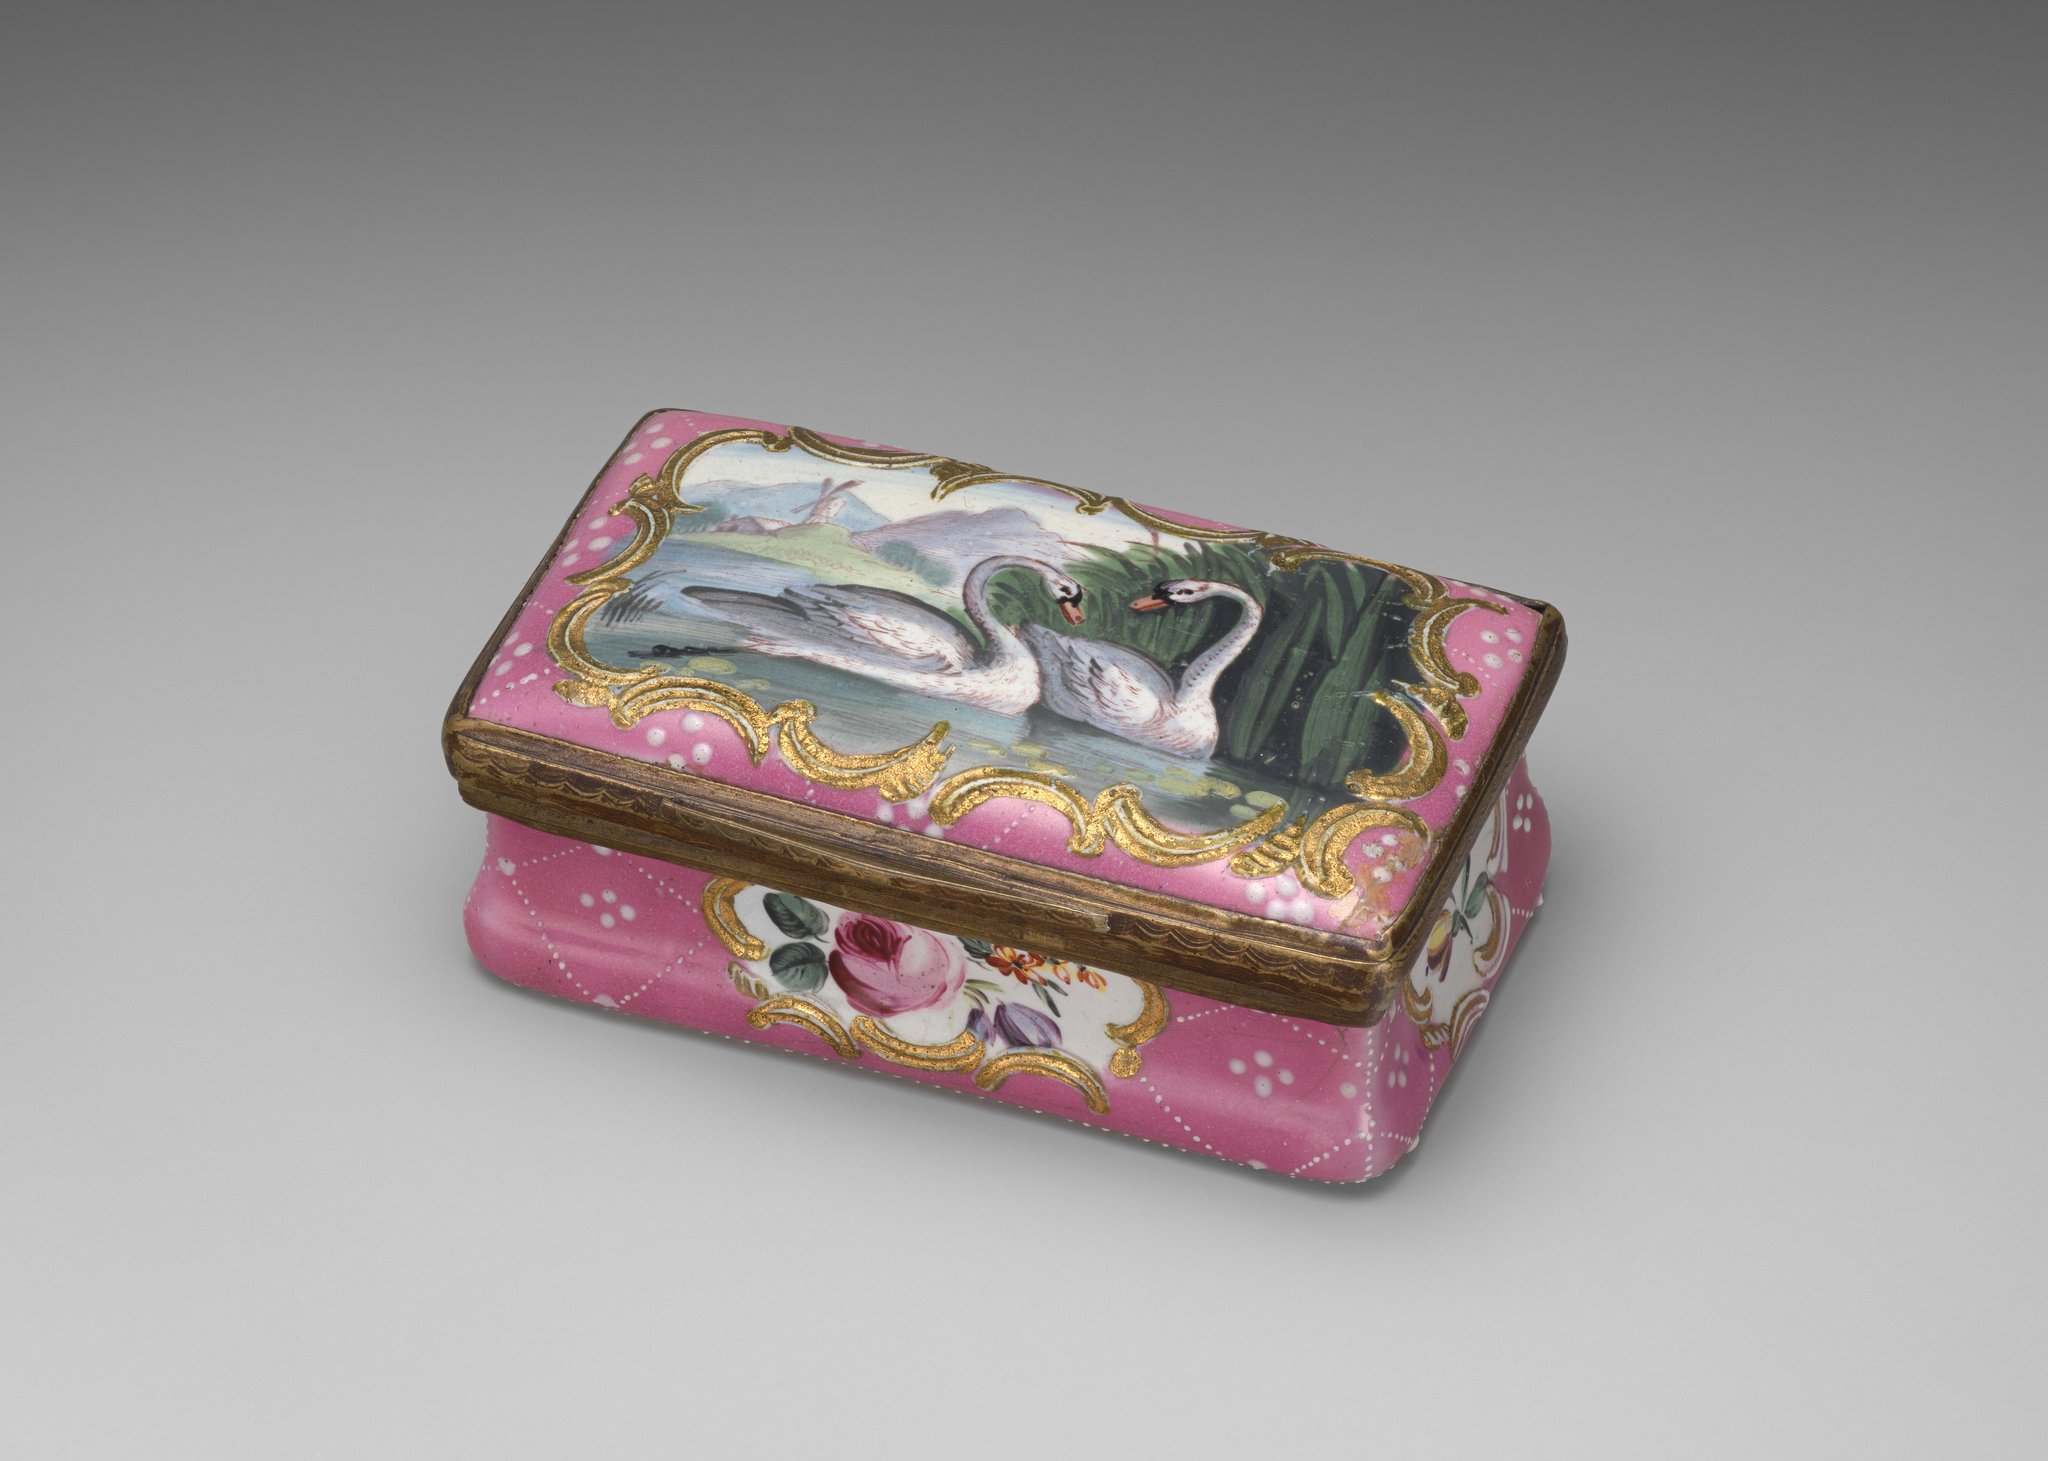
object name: snuffbox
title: Snuffbox with pair of swans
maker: wenceslaus hollar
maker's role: engraver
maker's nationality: bohemian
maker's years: 1607-1677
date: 1765-1770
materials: copper, enamel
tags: swans